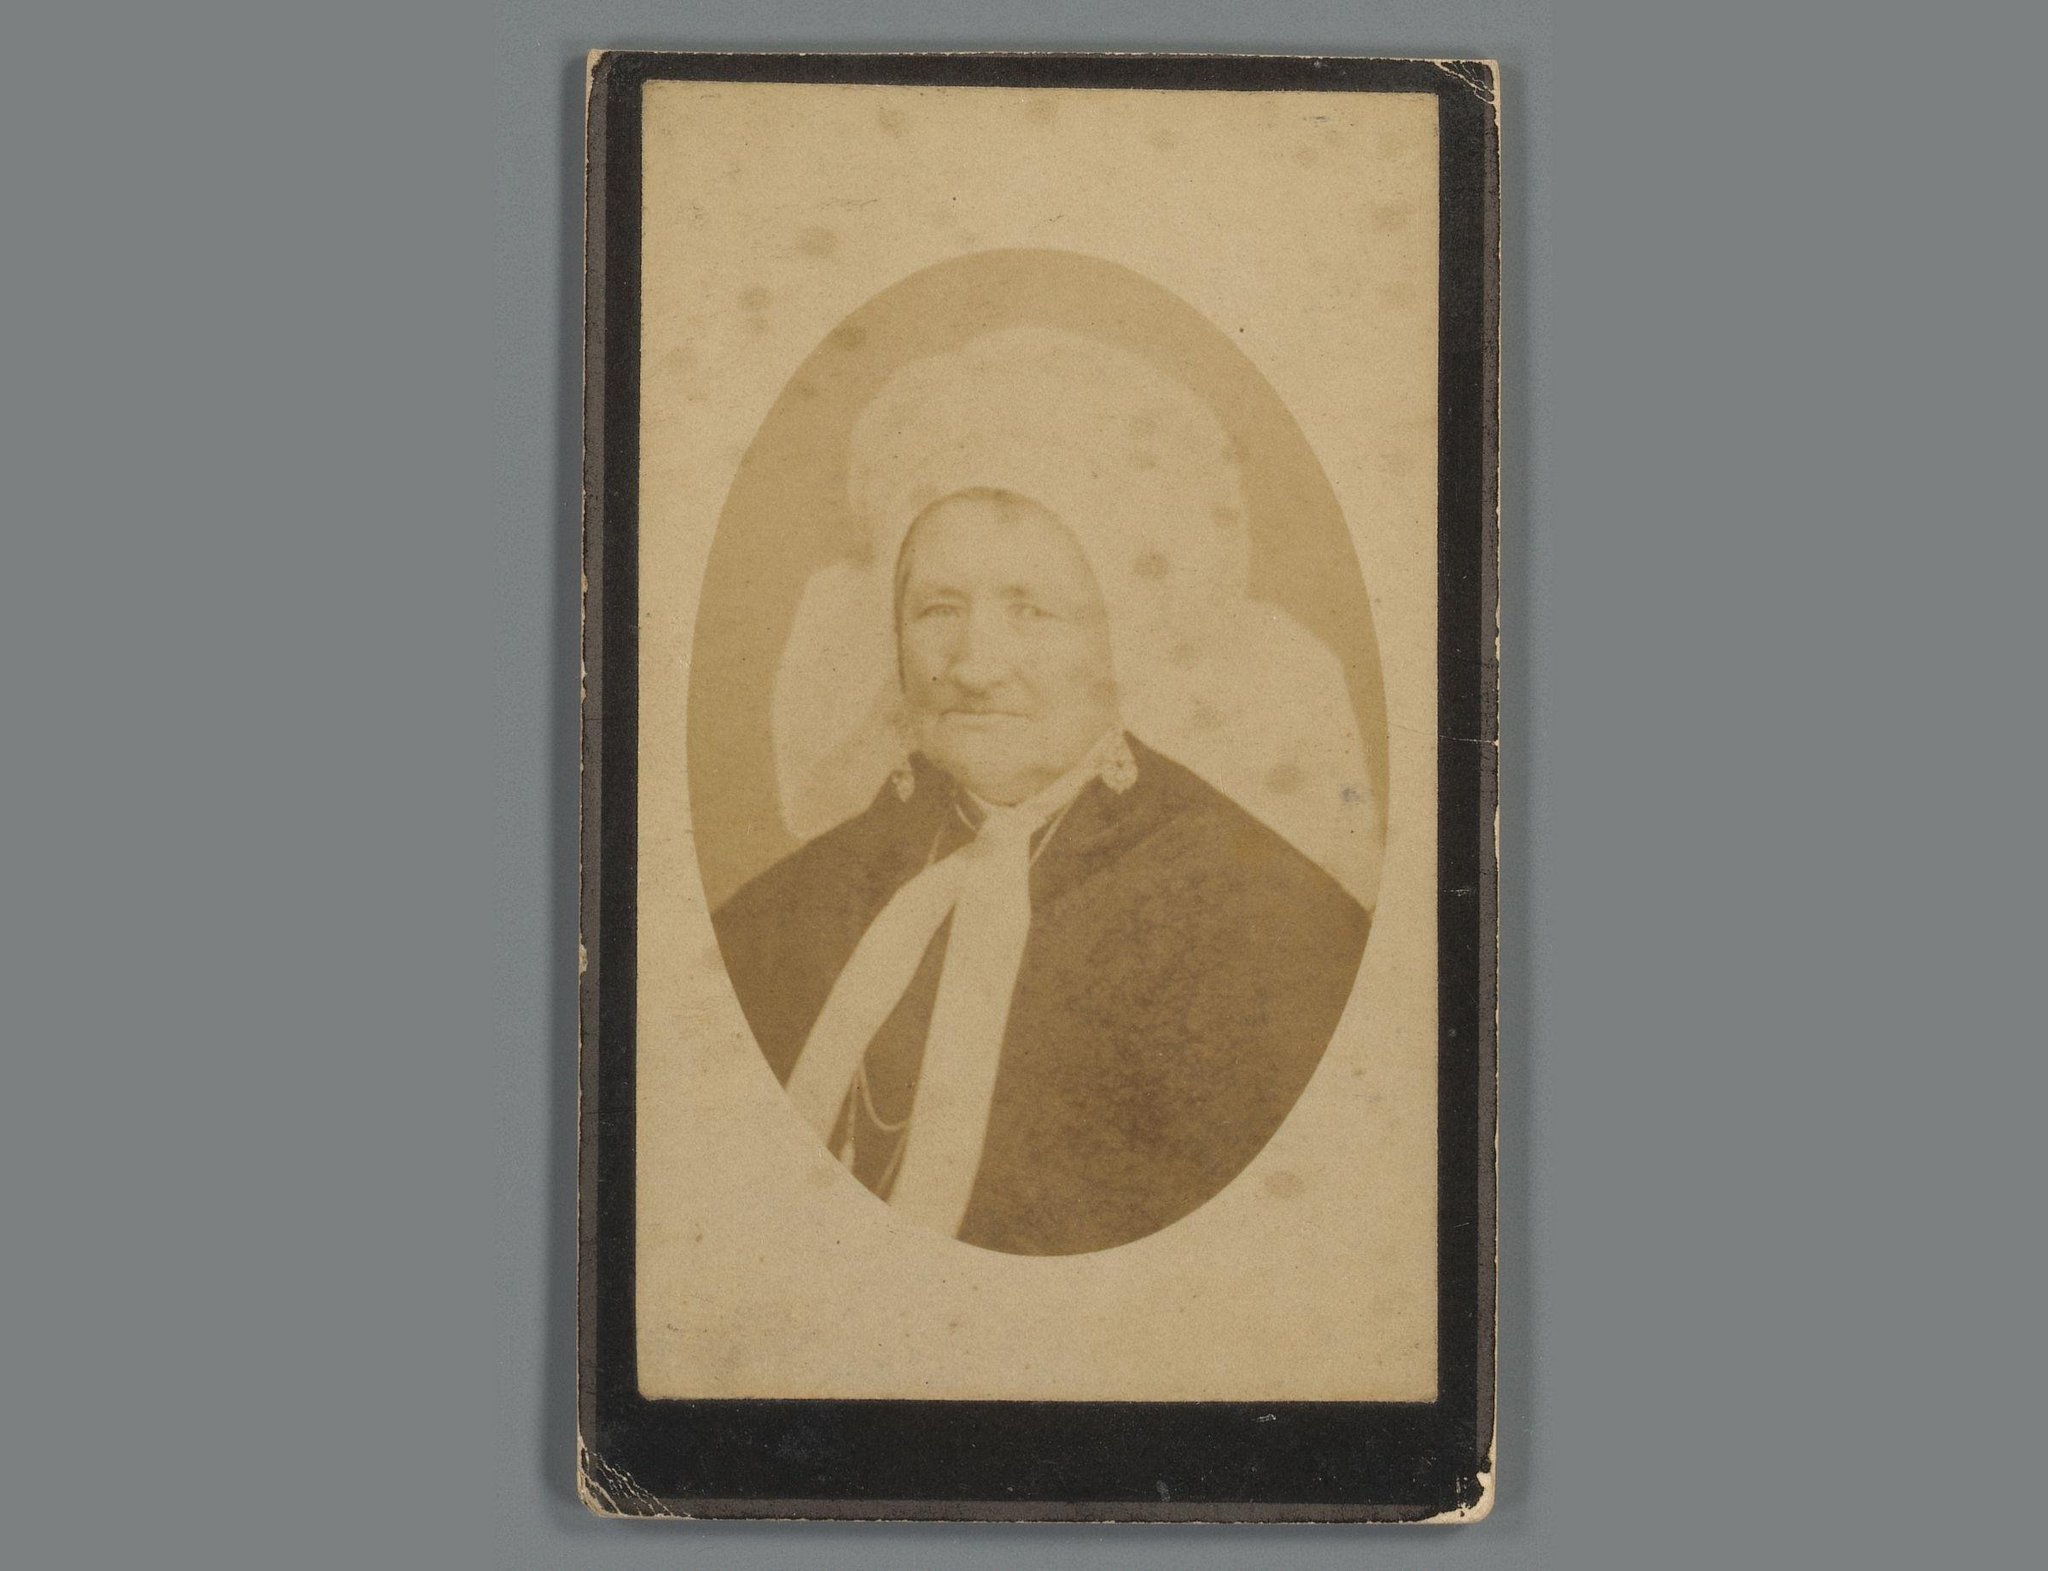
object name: prayer card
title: Portret van Wilhelmina van Schijndel op bidprent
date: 1887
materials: cardboard, paper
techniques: albumen print, letterpress printing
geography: heusden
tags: adult woman, historical persons, folk costume, regional costume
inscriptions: inscription: ‘In uwe godvruchtige gebeden worden aanbevolen/ de Zielen van Zaliger/ Johannes van Dieten (...) en zijne Echtgenoote/ Wilhelmina van Schijndel (...) H.J. Wassen, Heusden.’